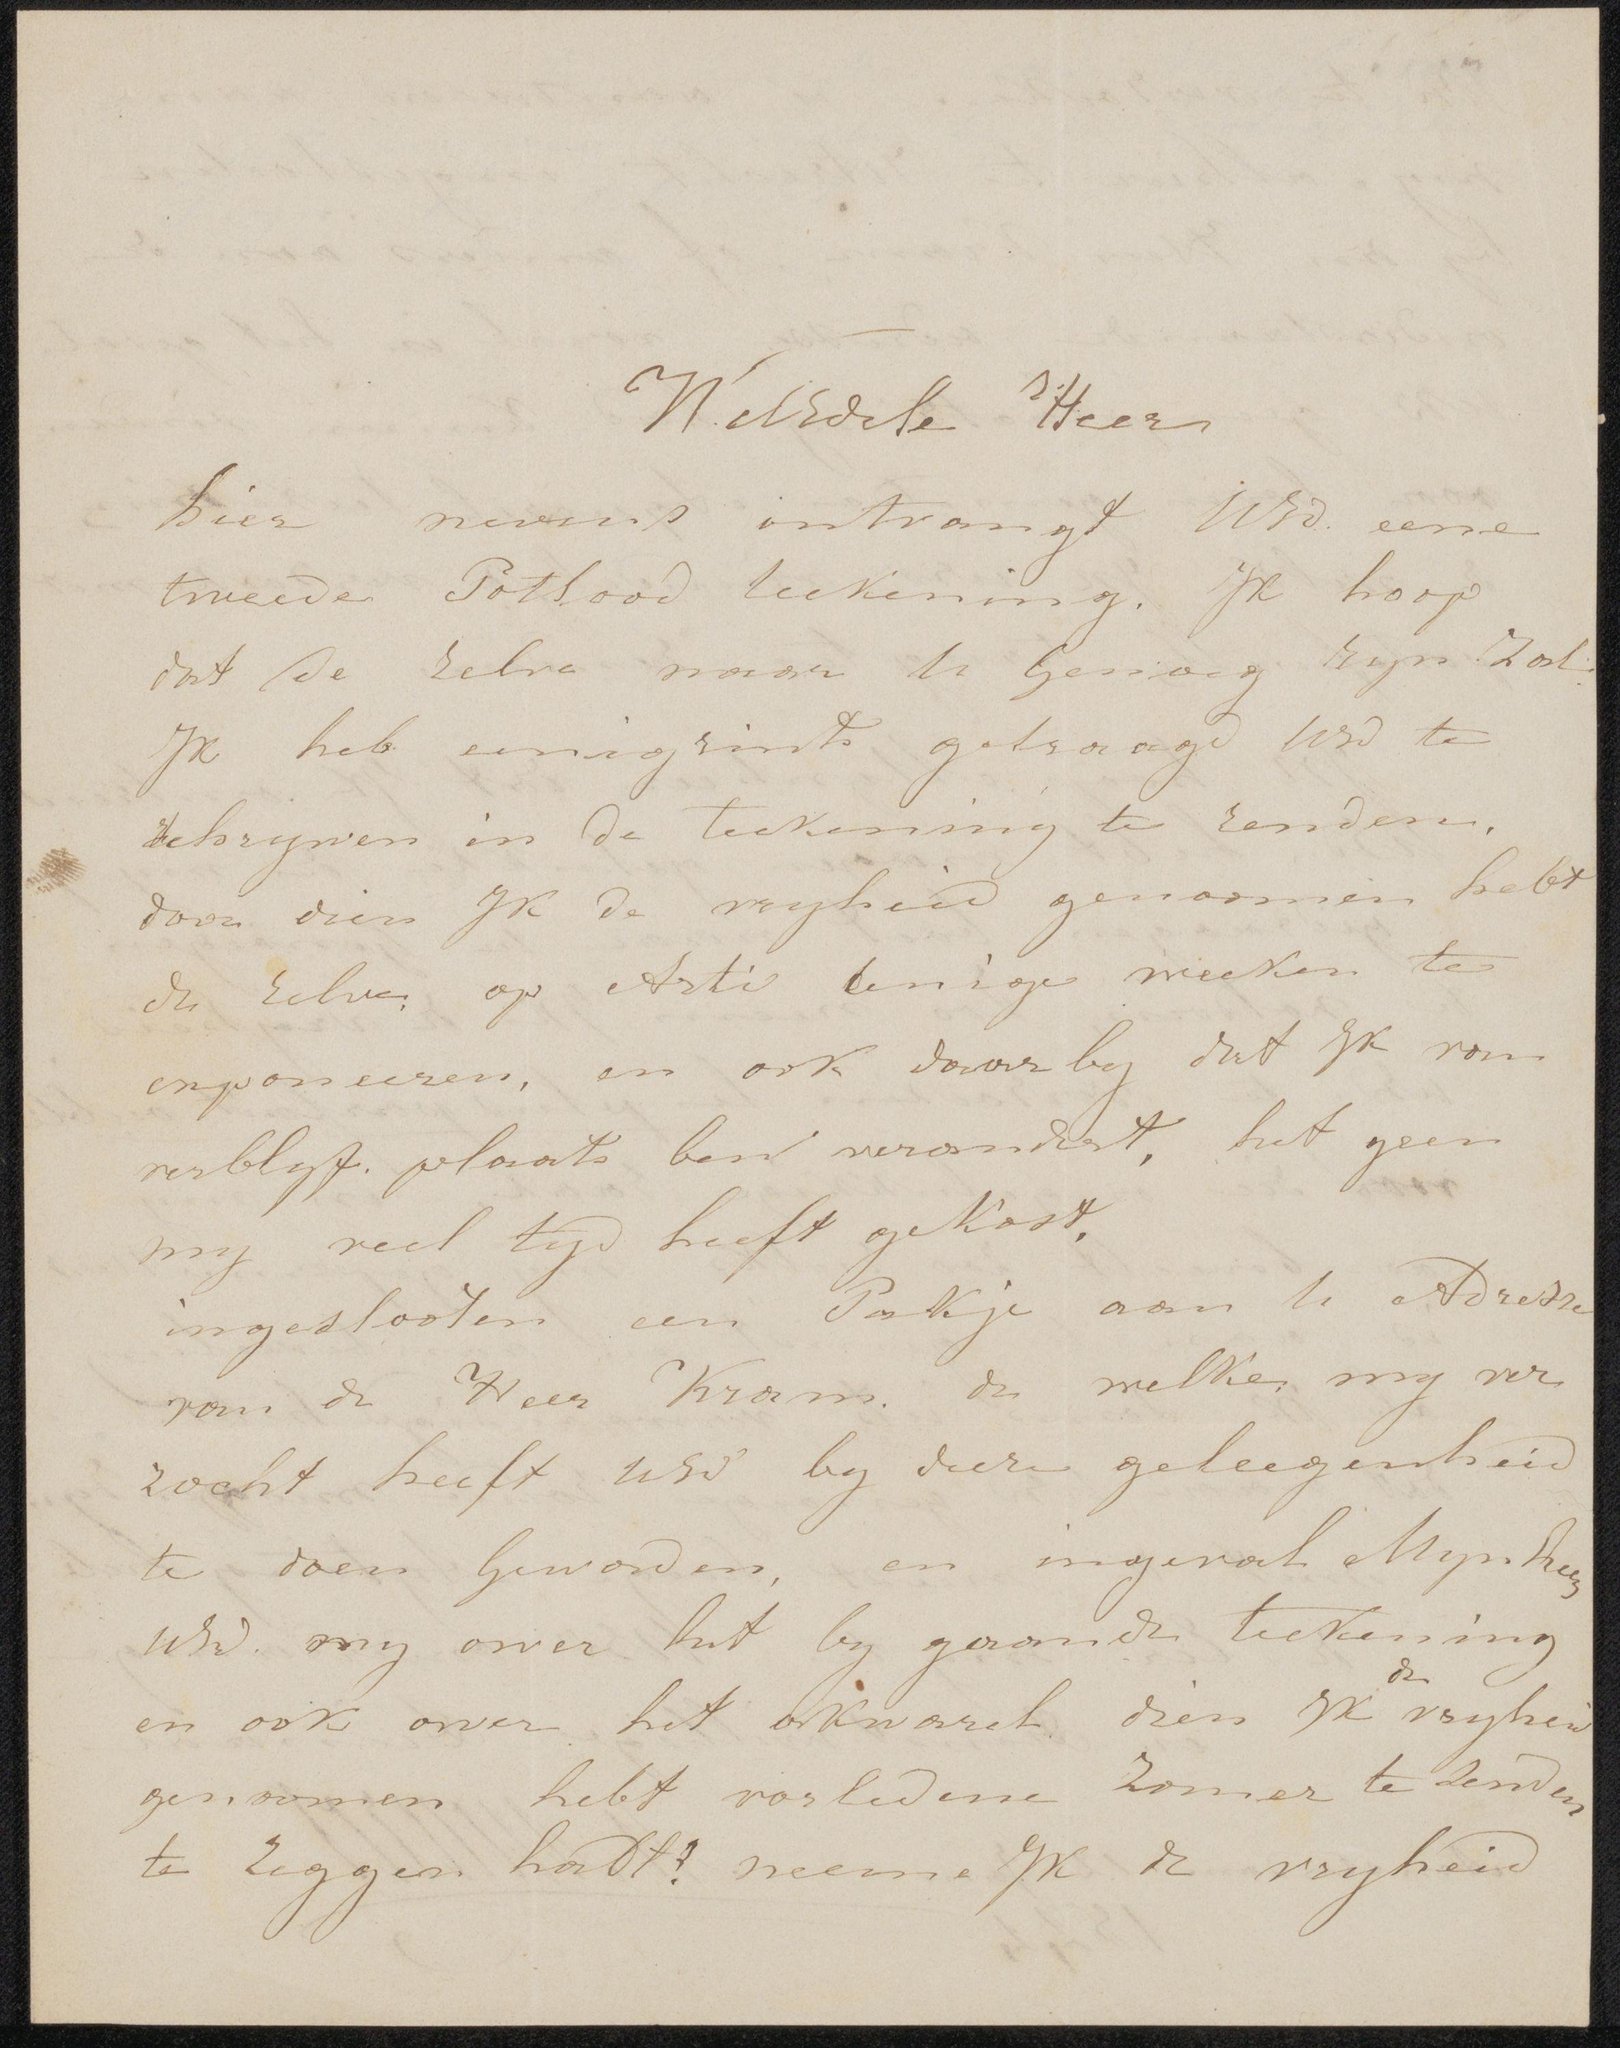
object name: letter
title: Brief aan Adriaan van der Willigen Pz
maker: michel mourot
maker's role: draughtsman, print maker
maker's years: 1803-1847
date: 1844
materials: ink, paper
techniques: pen, writing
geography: amsterdam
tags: utrecht, print maker, draughtsman, christiaan kramm, drawing, exhibition ~ art